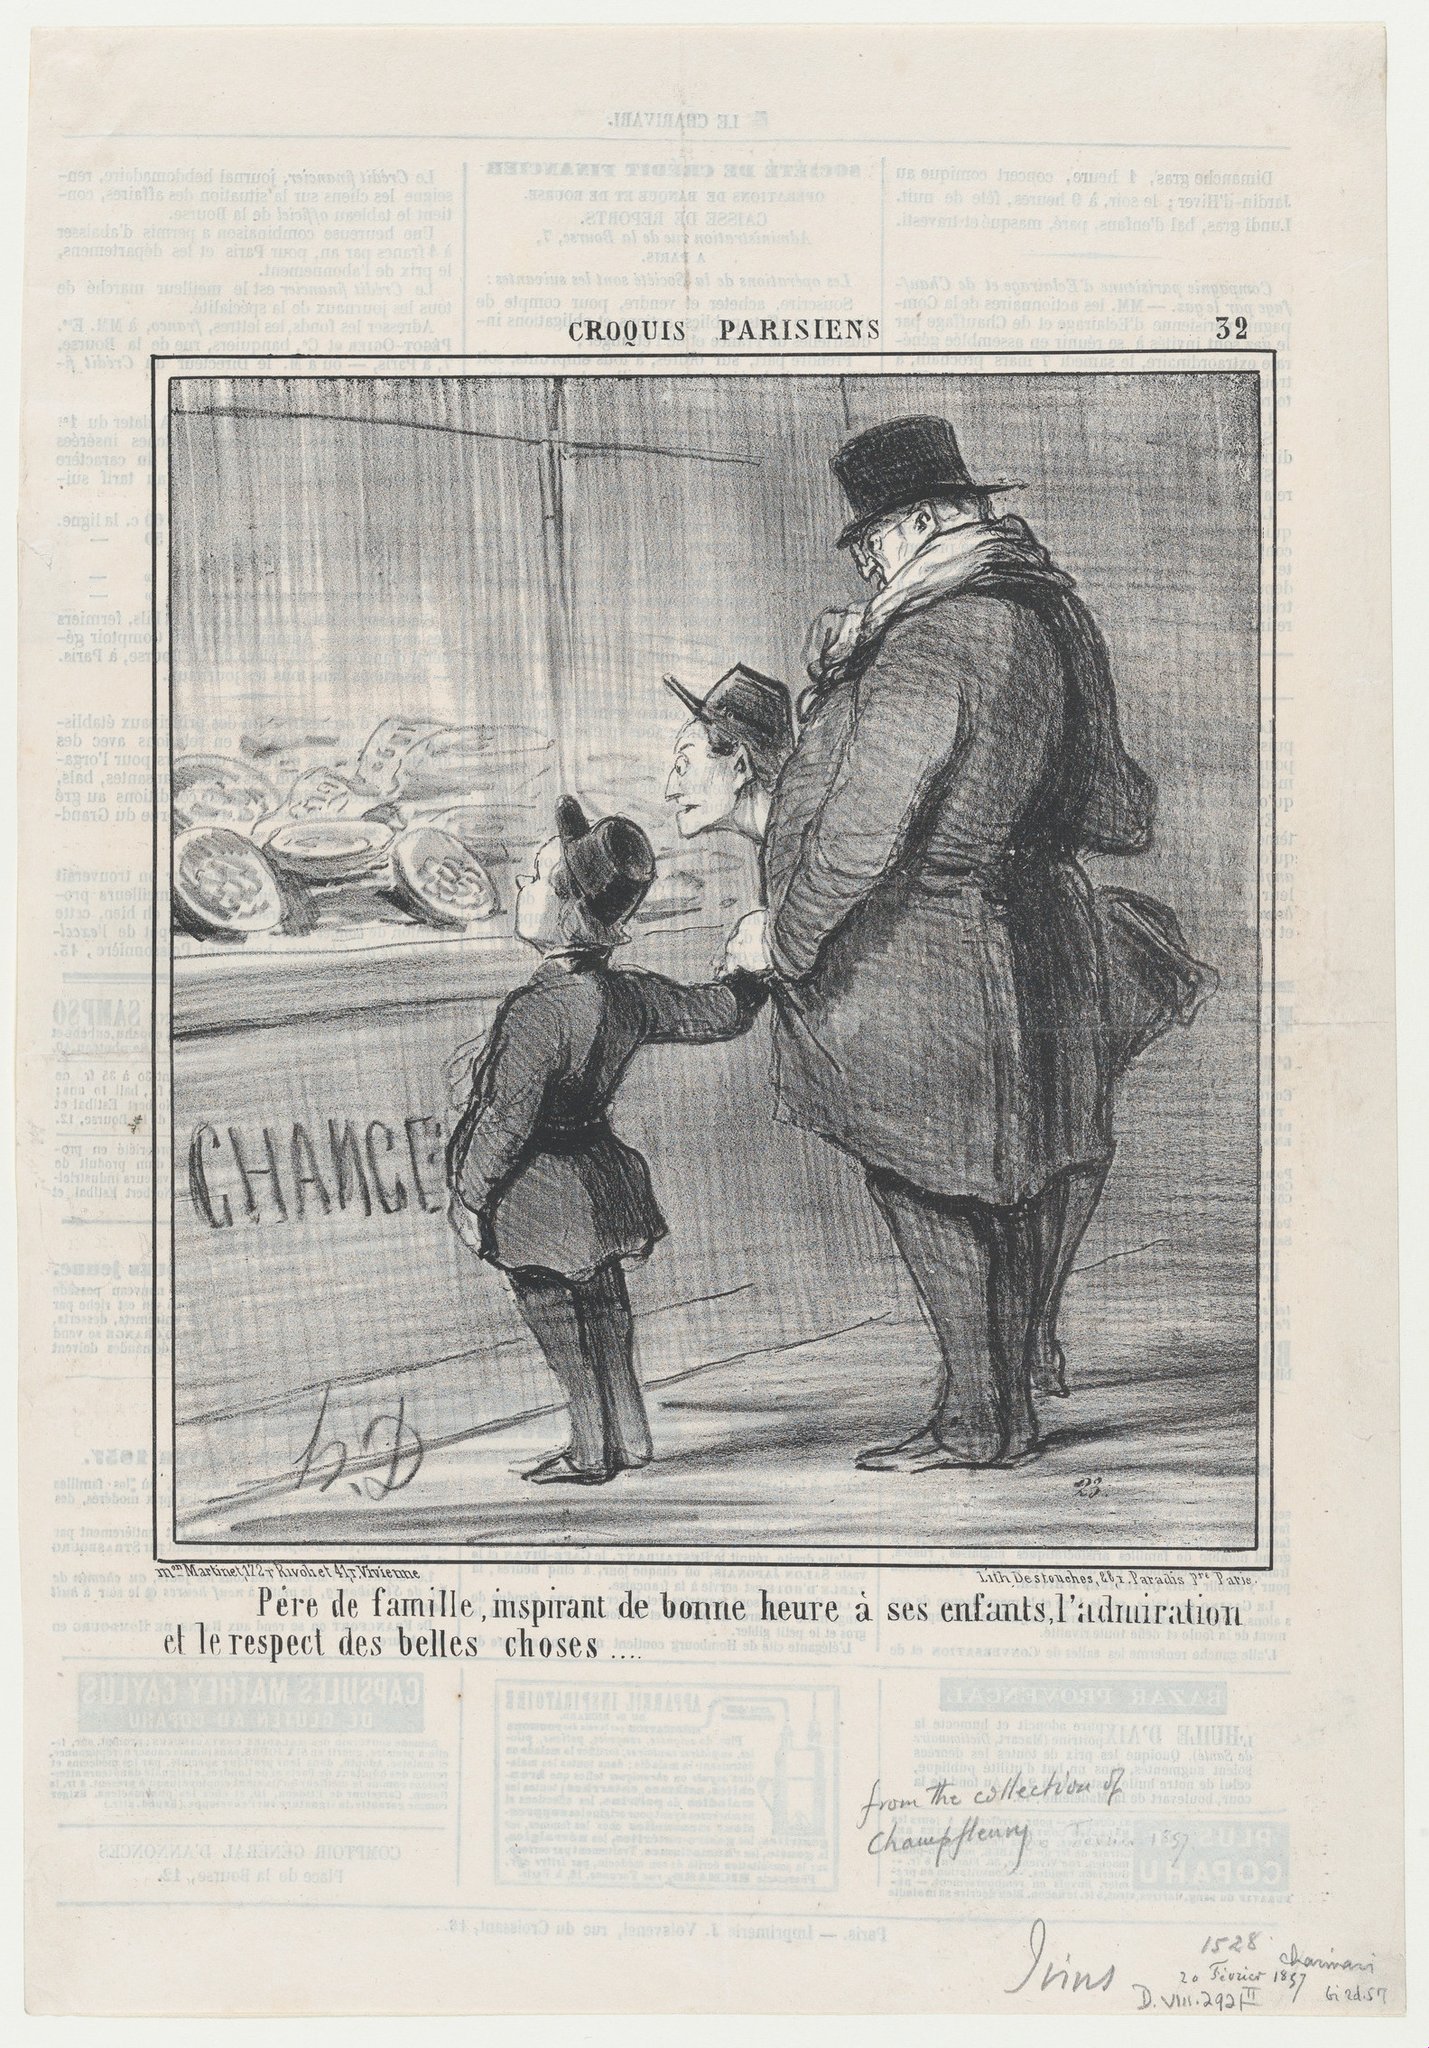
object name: print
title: La Visite à l'Atelier, from Croquis Parisiens, published in Le Charivari, May 22, 1857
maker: honoré daumier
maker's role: artist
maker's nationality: french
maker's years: 1808-1879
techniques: lithograph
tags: boys,men